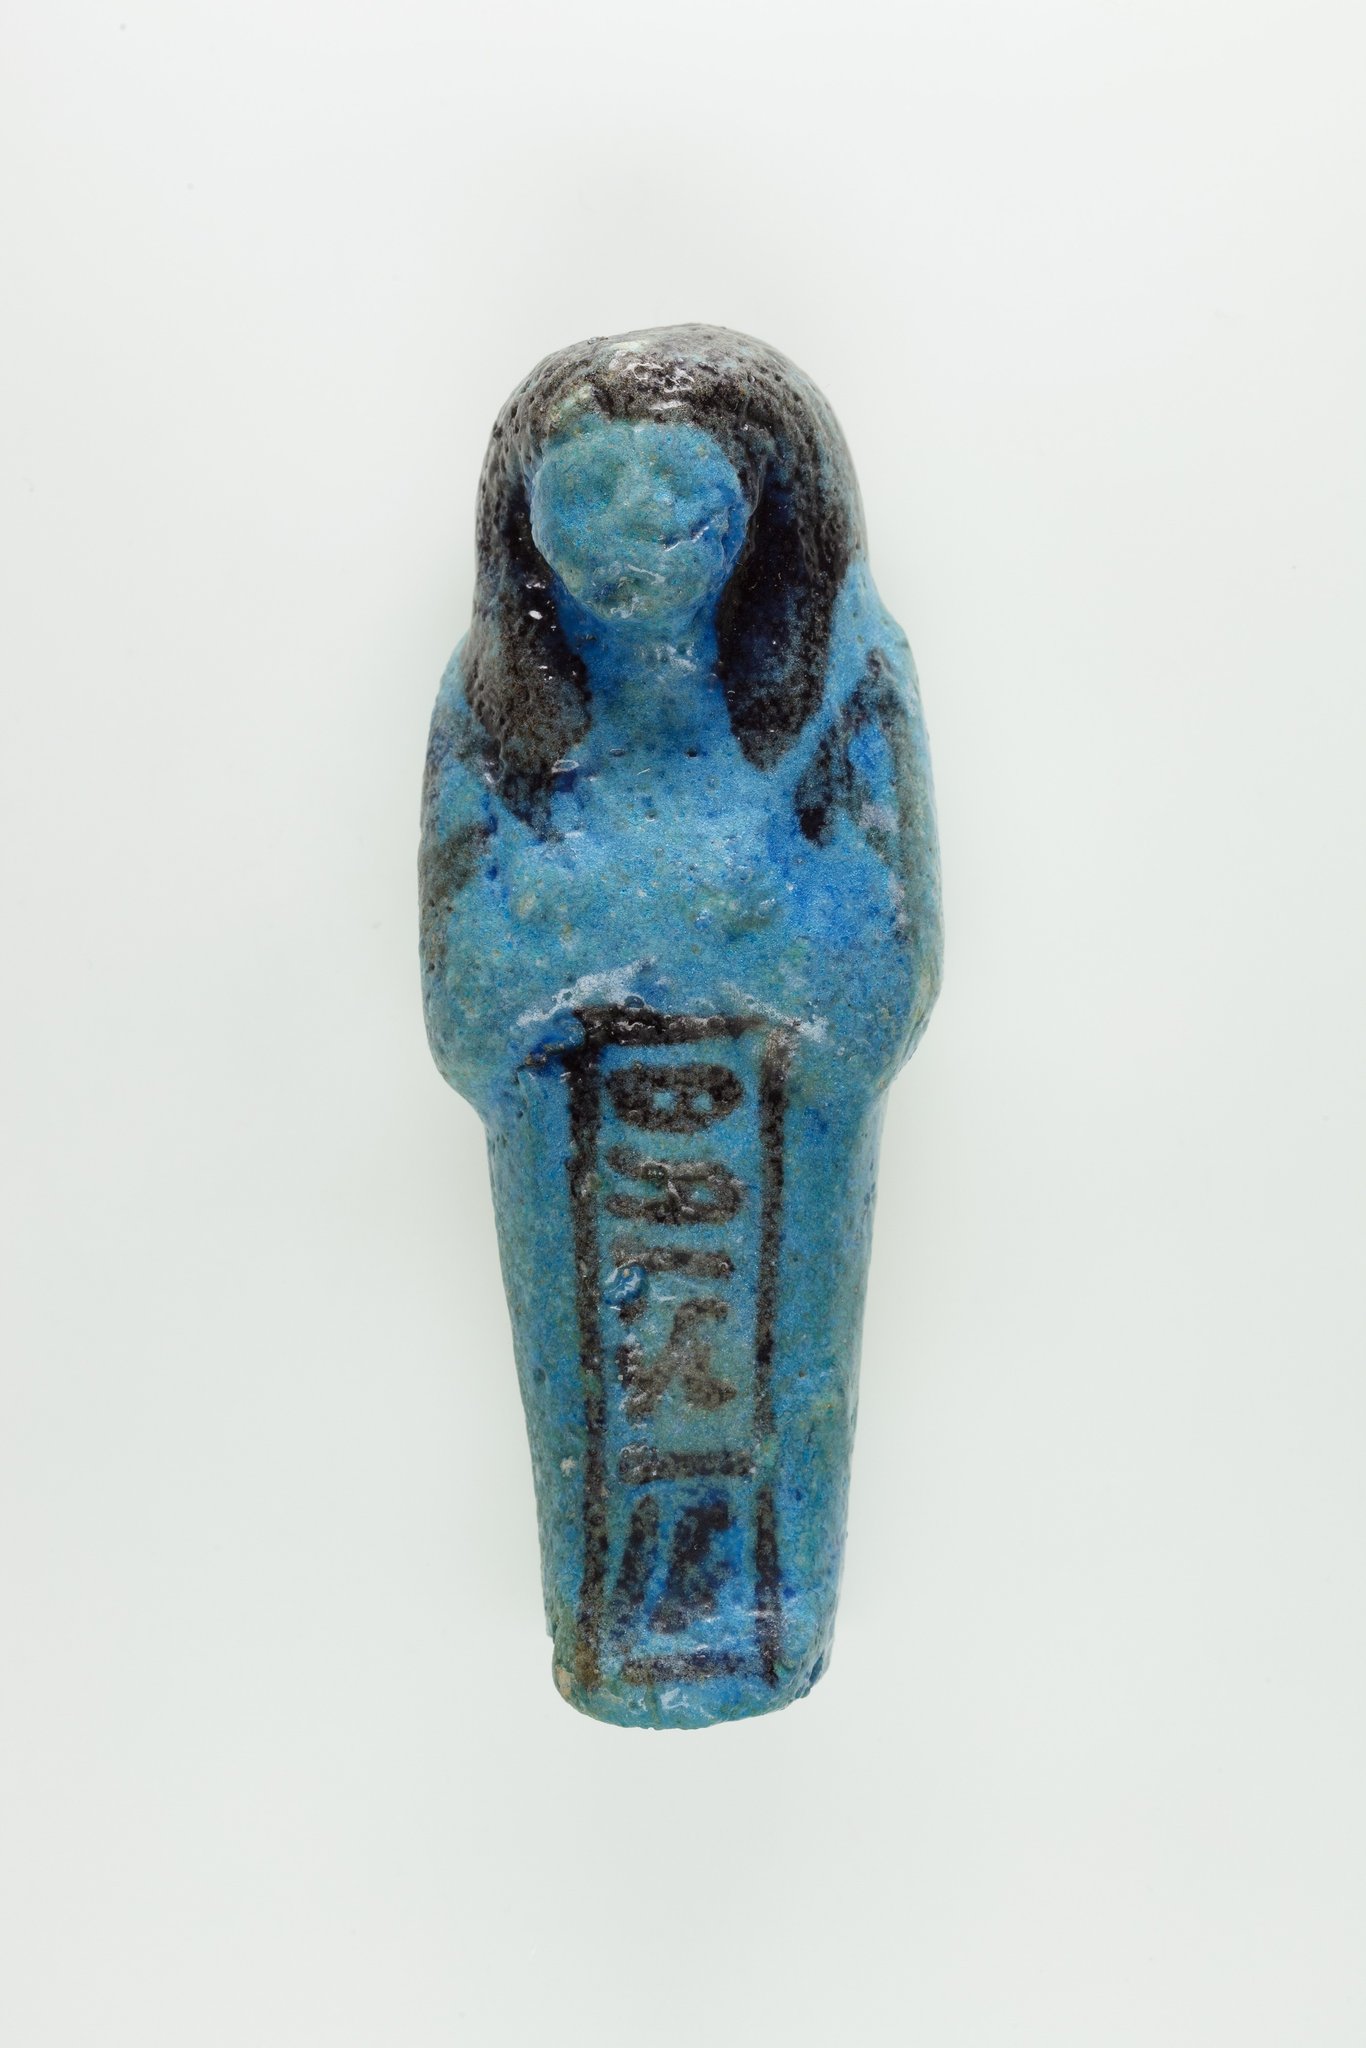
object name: shabti, worker, nauny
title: Worker Shabti of Nauny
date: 1050 BCE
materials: faience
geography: egypt